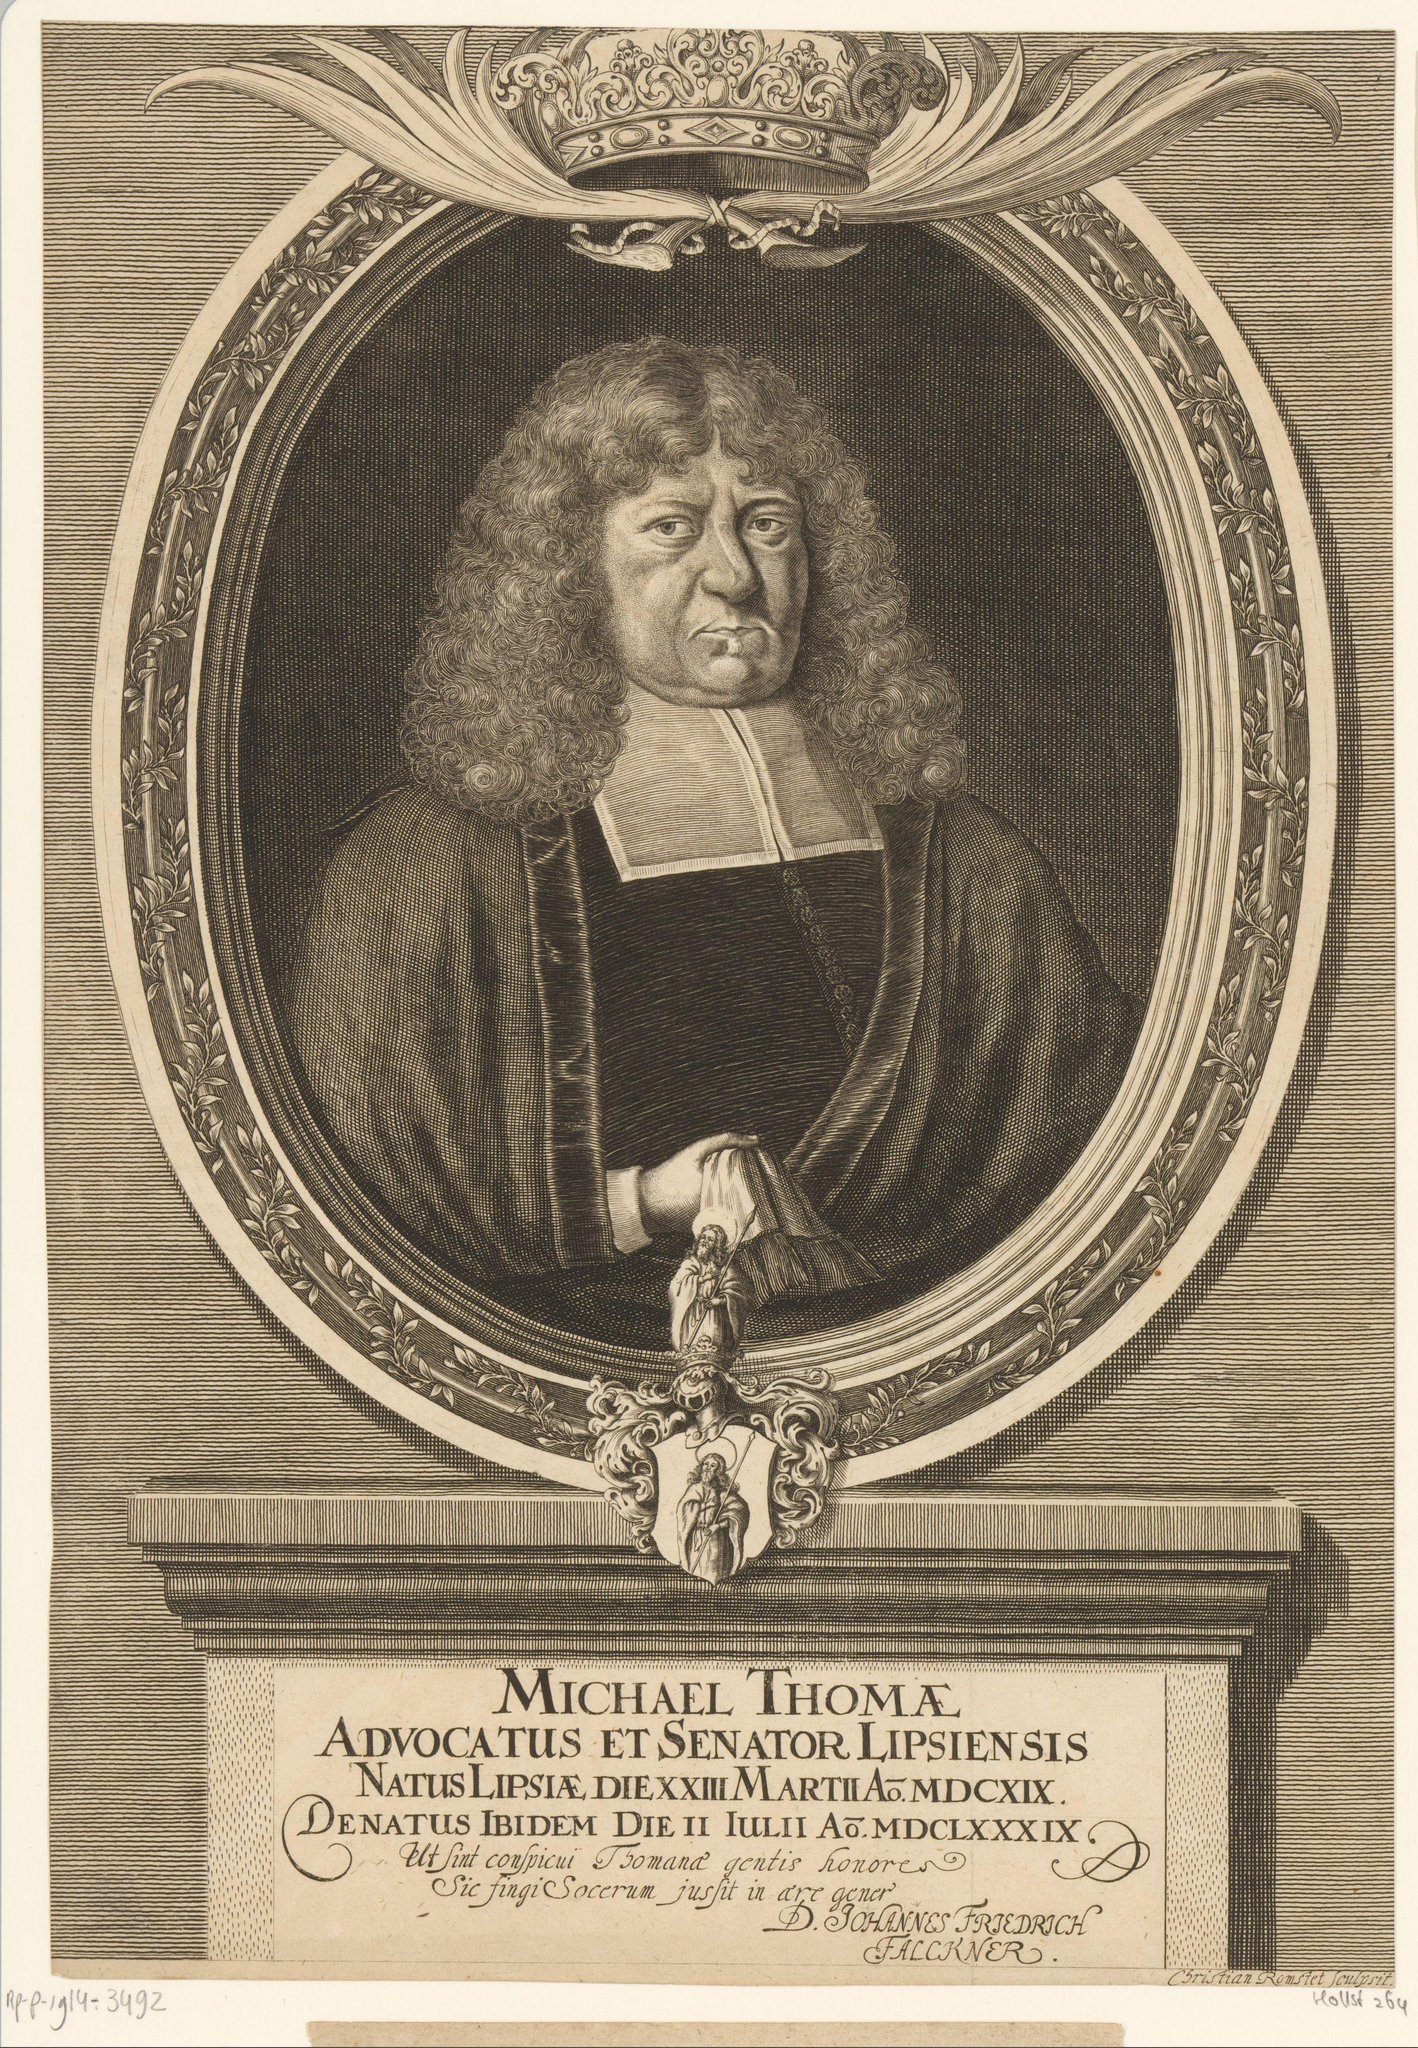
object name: print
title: Portret van Michael Thomae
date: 1665-1721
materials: paper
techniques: engraving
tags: crown (symbol of sovereignty), historical persons, armorial bearing, heraldry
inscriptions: collector's mark: Lugt 2228